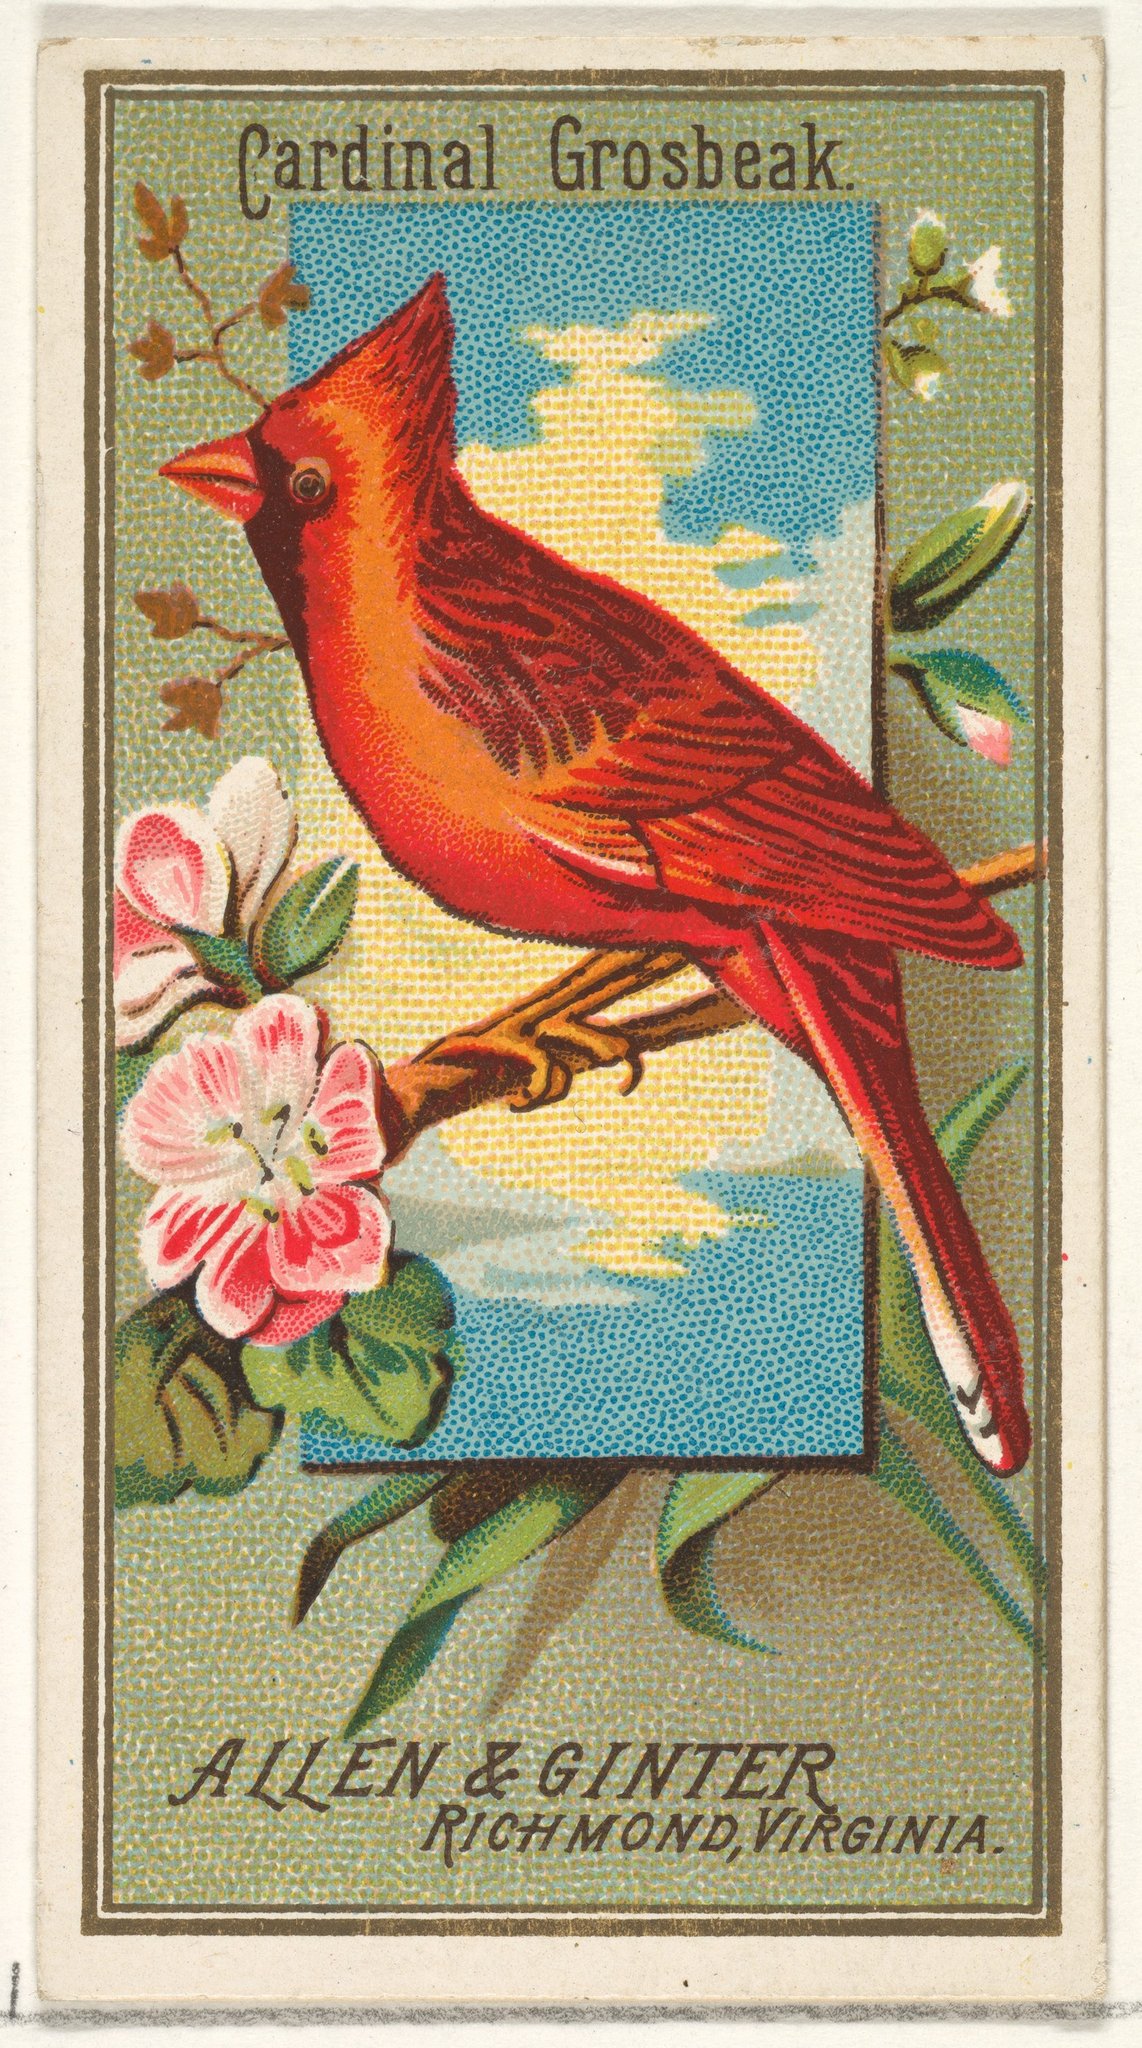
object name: print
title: Cardinal Grosbeak, from the Birds of America series (N4) for Allen & Ginter Cigarettes Brands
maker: allen & ginter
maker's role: publisher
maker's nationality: american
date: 1888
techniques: color lithograph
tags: birds